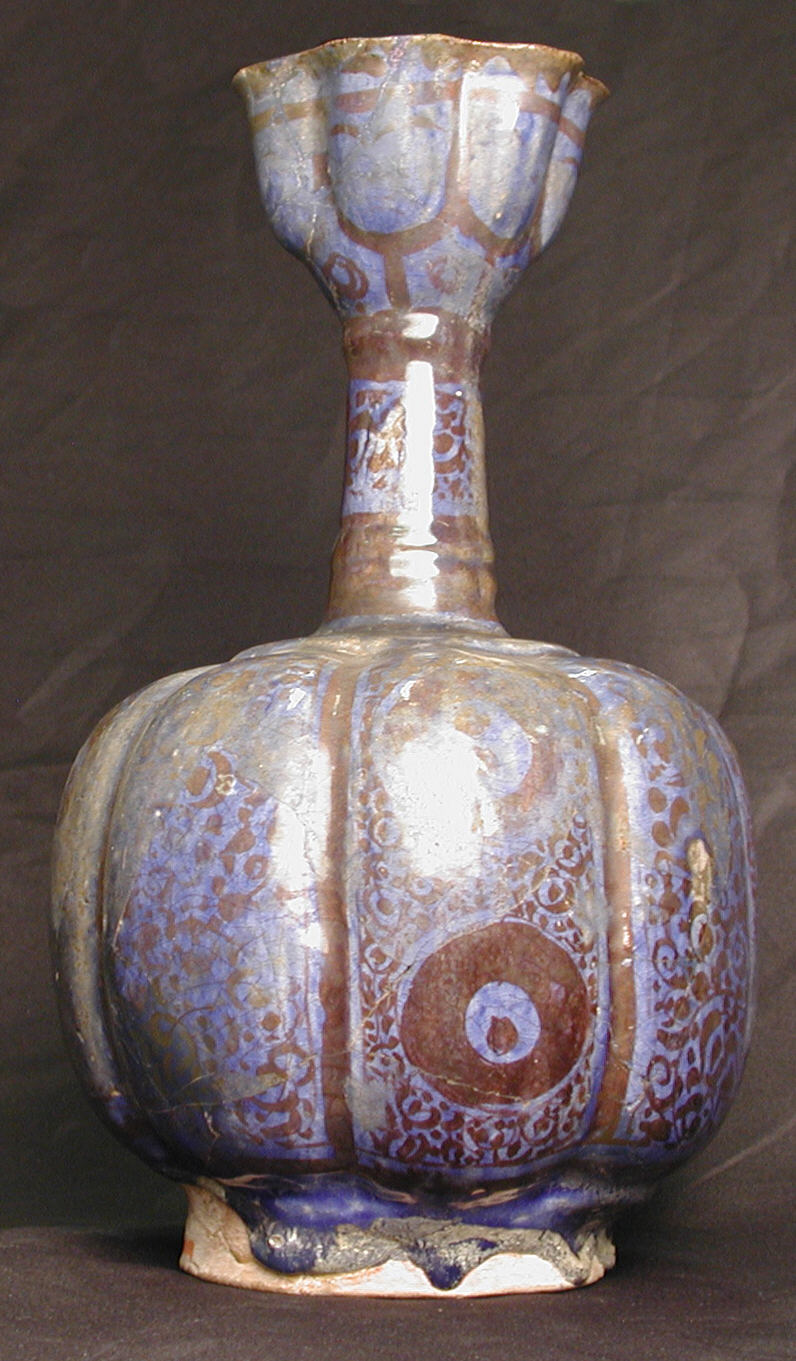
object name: vase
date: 1101-1233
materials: stonepaste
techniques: luster painting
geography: iran